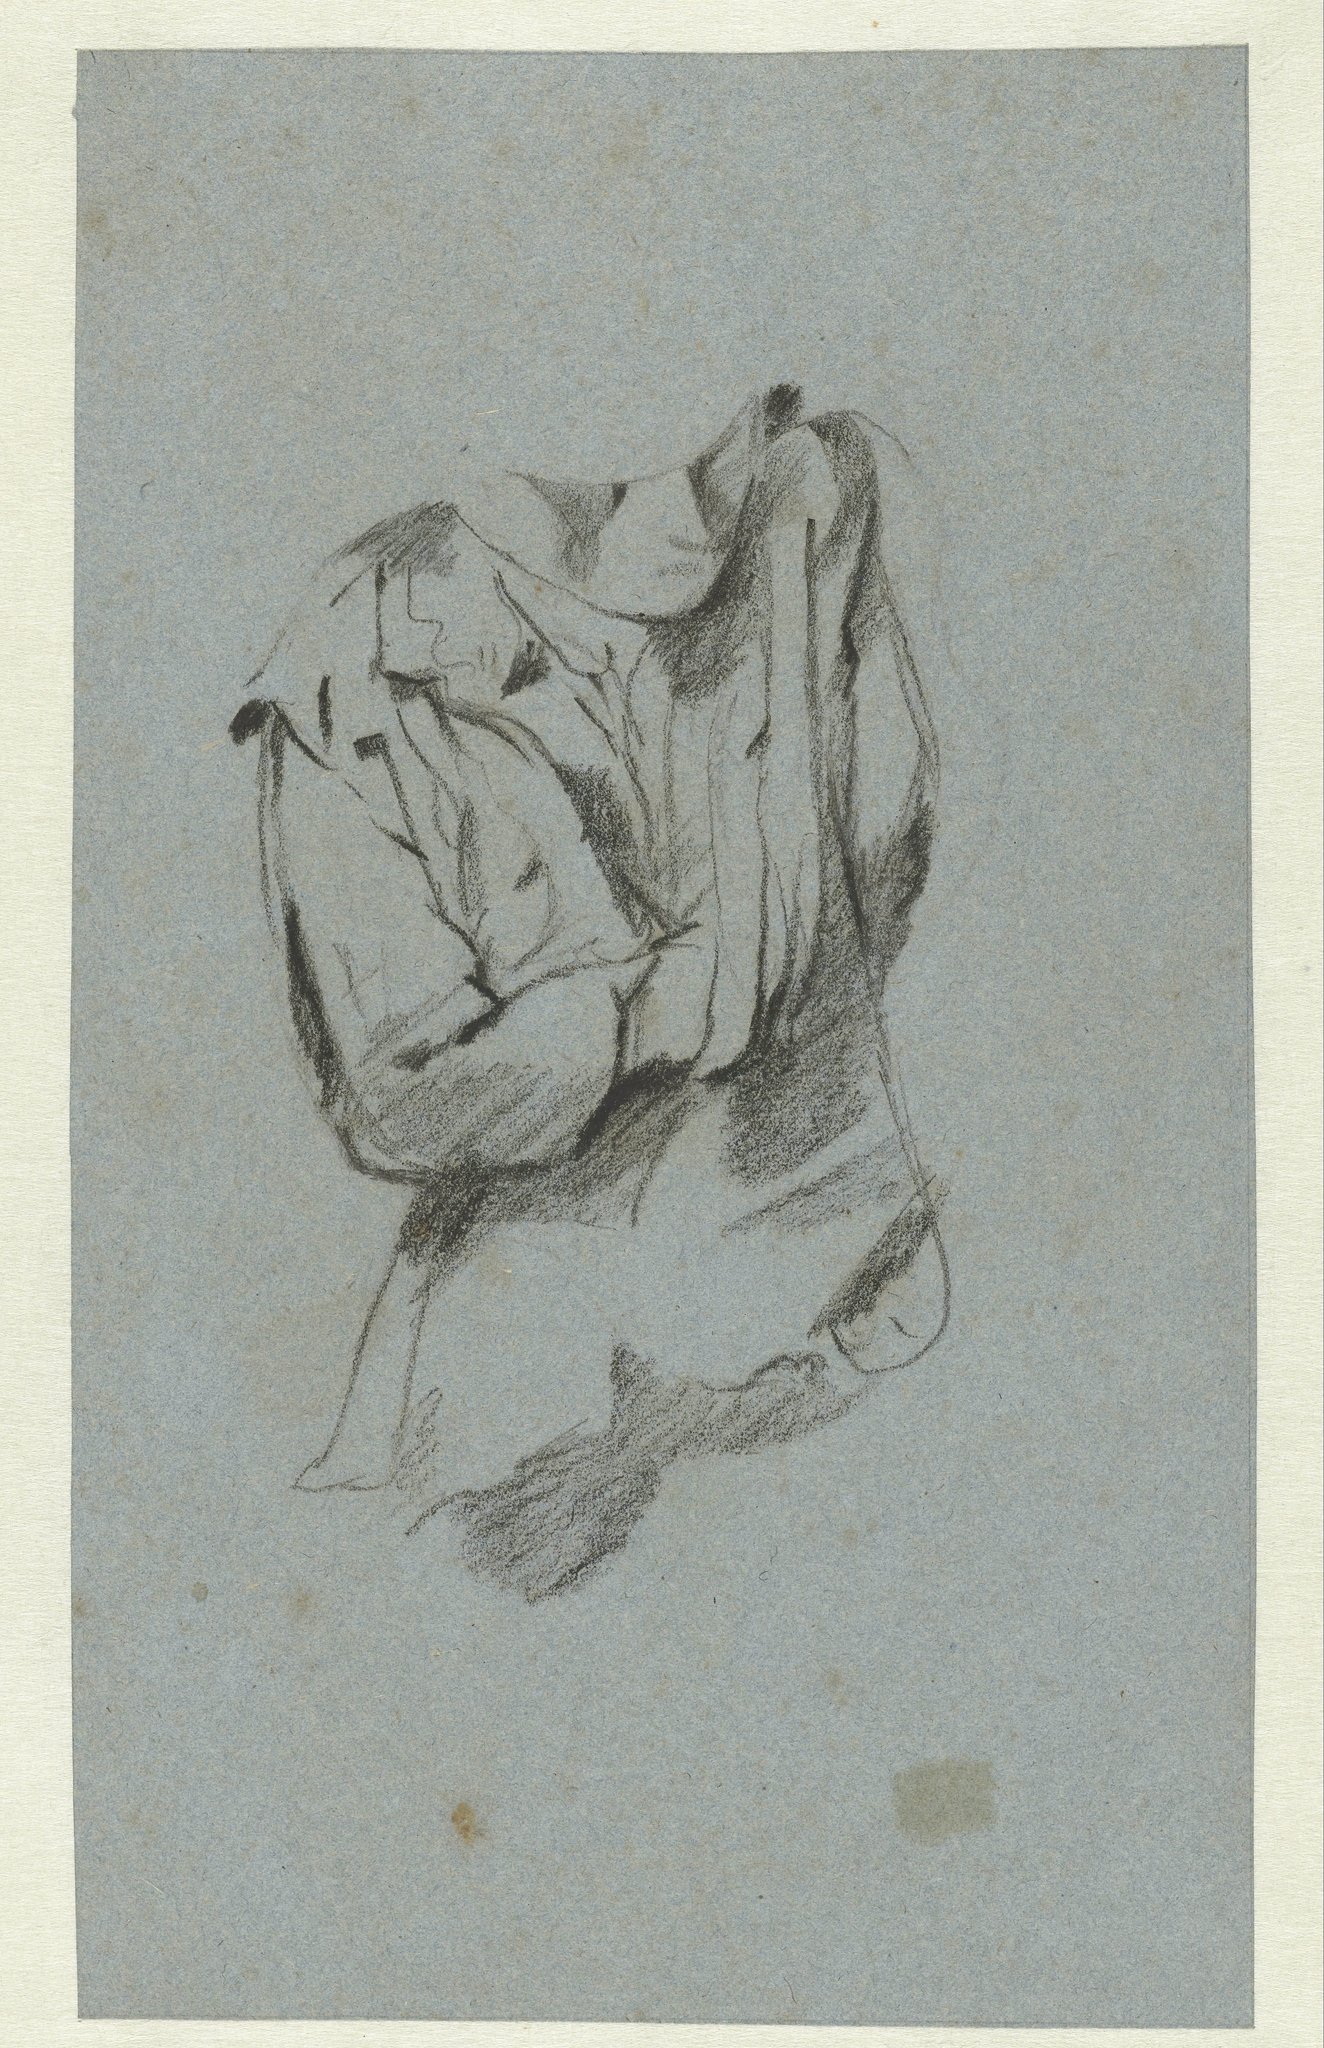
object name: drawing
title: Schets van een man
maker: jan havicksz. steen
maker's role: painter, print maker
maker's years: 1625-1679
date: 1636-1679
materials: chalk, paper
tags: standing figure